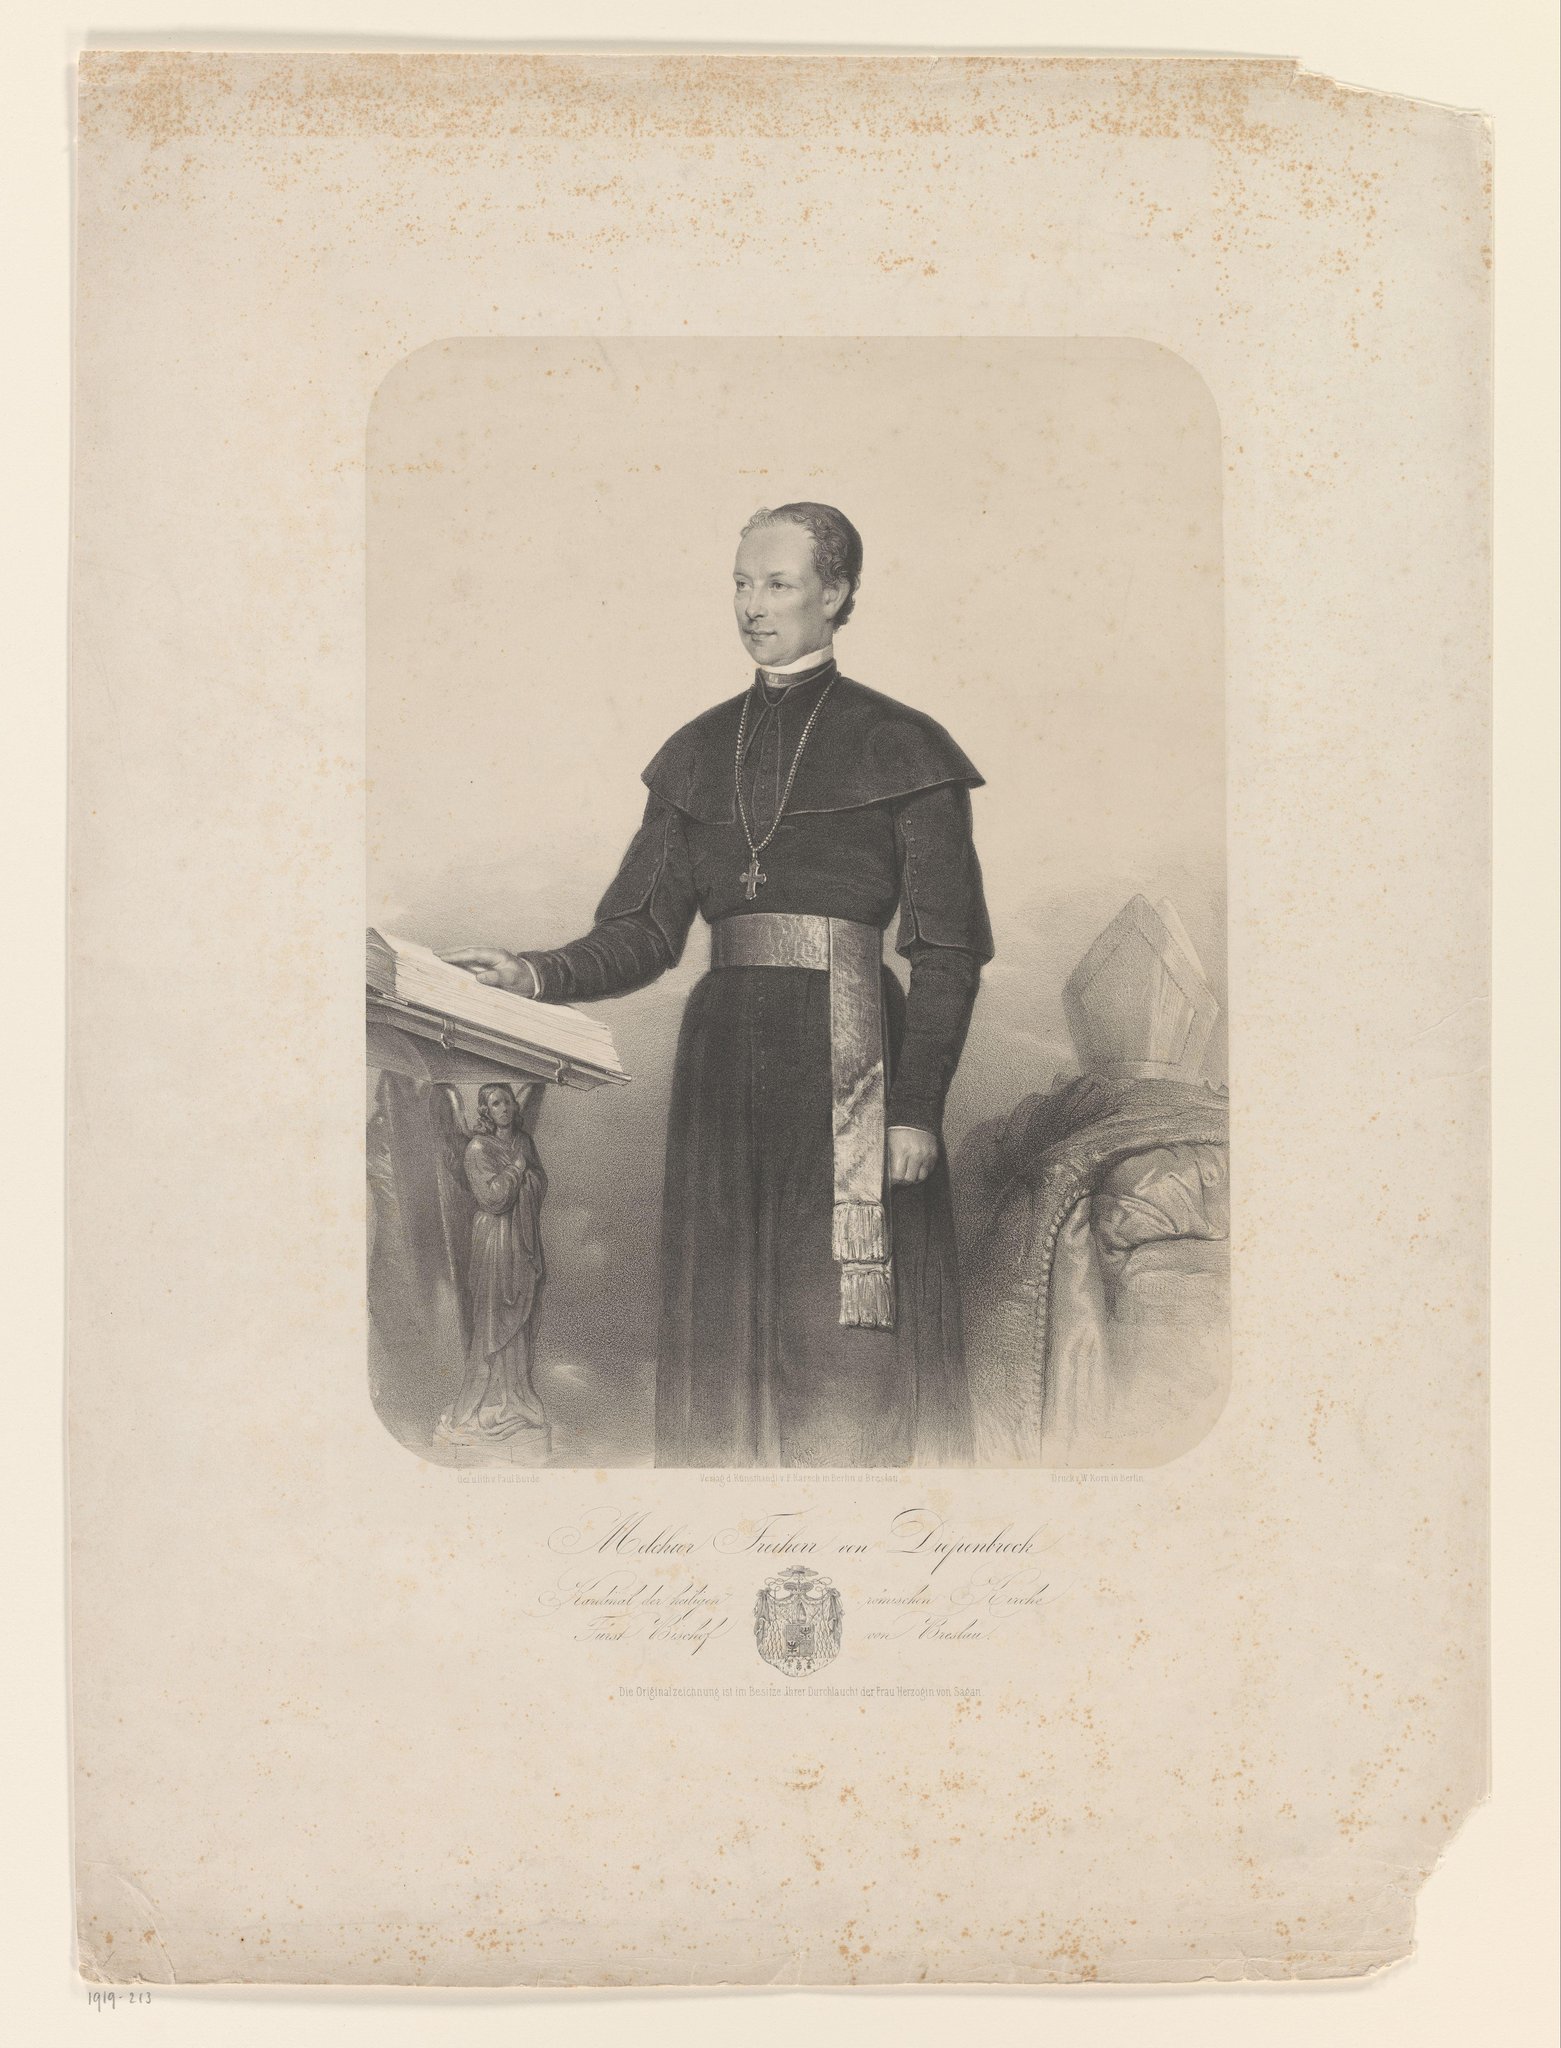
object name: print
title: Portret van Melchior von Diepenbrock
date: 1829-1874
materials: paper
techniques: tone lithography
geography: berlin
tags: priest, hierarchy of jurisdiction ~ roman catholic church, adult man, historical persons, the bible as a book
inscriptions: collector's mark: Lugt 2228, check stamp: ‘F. Karsch’